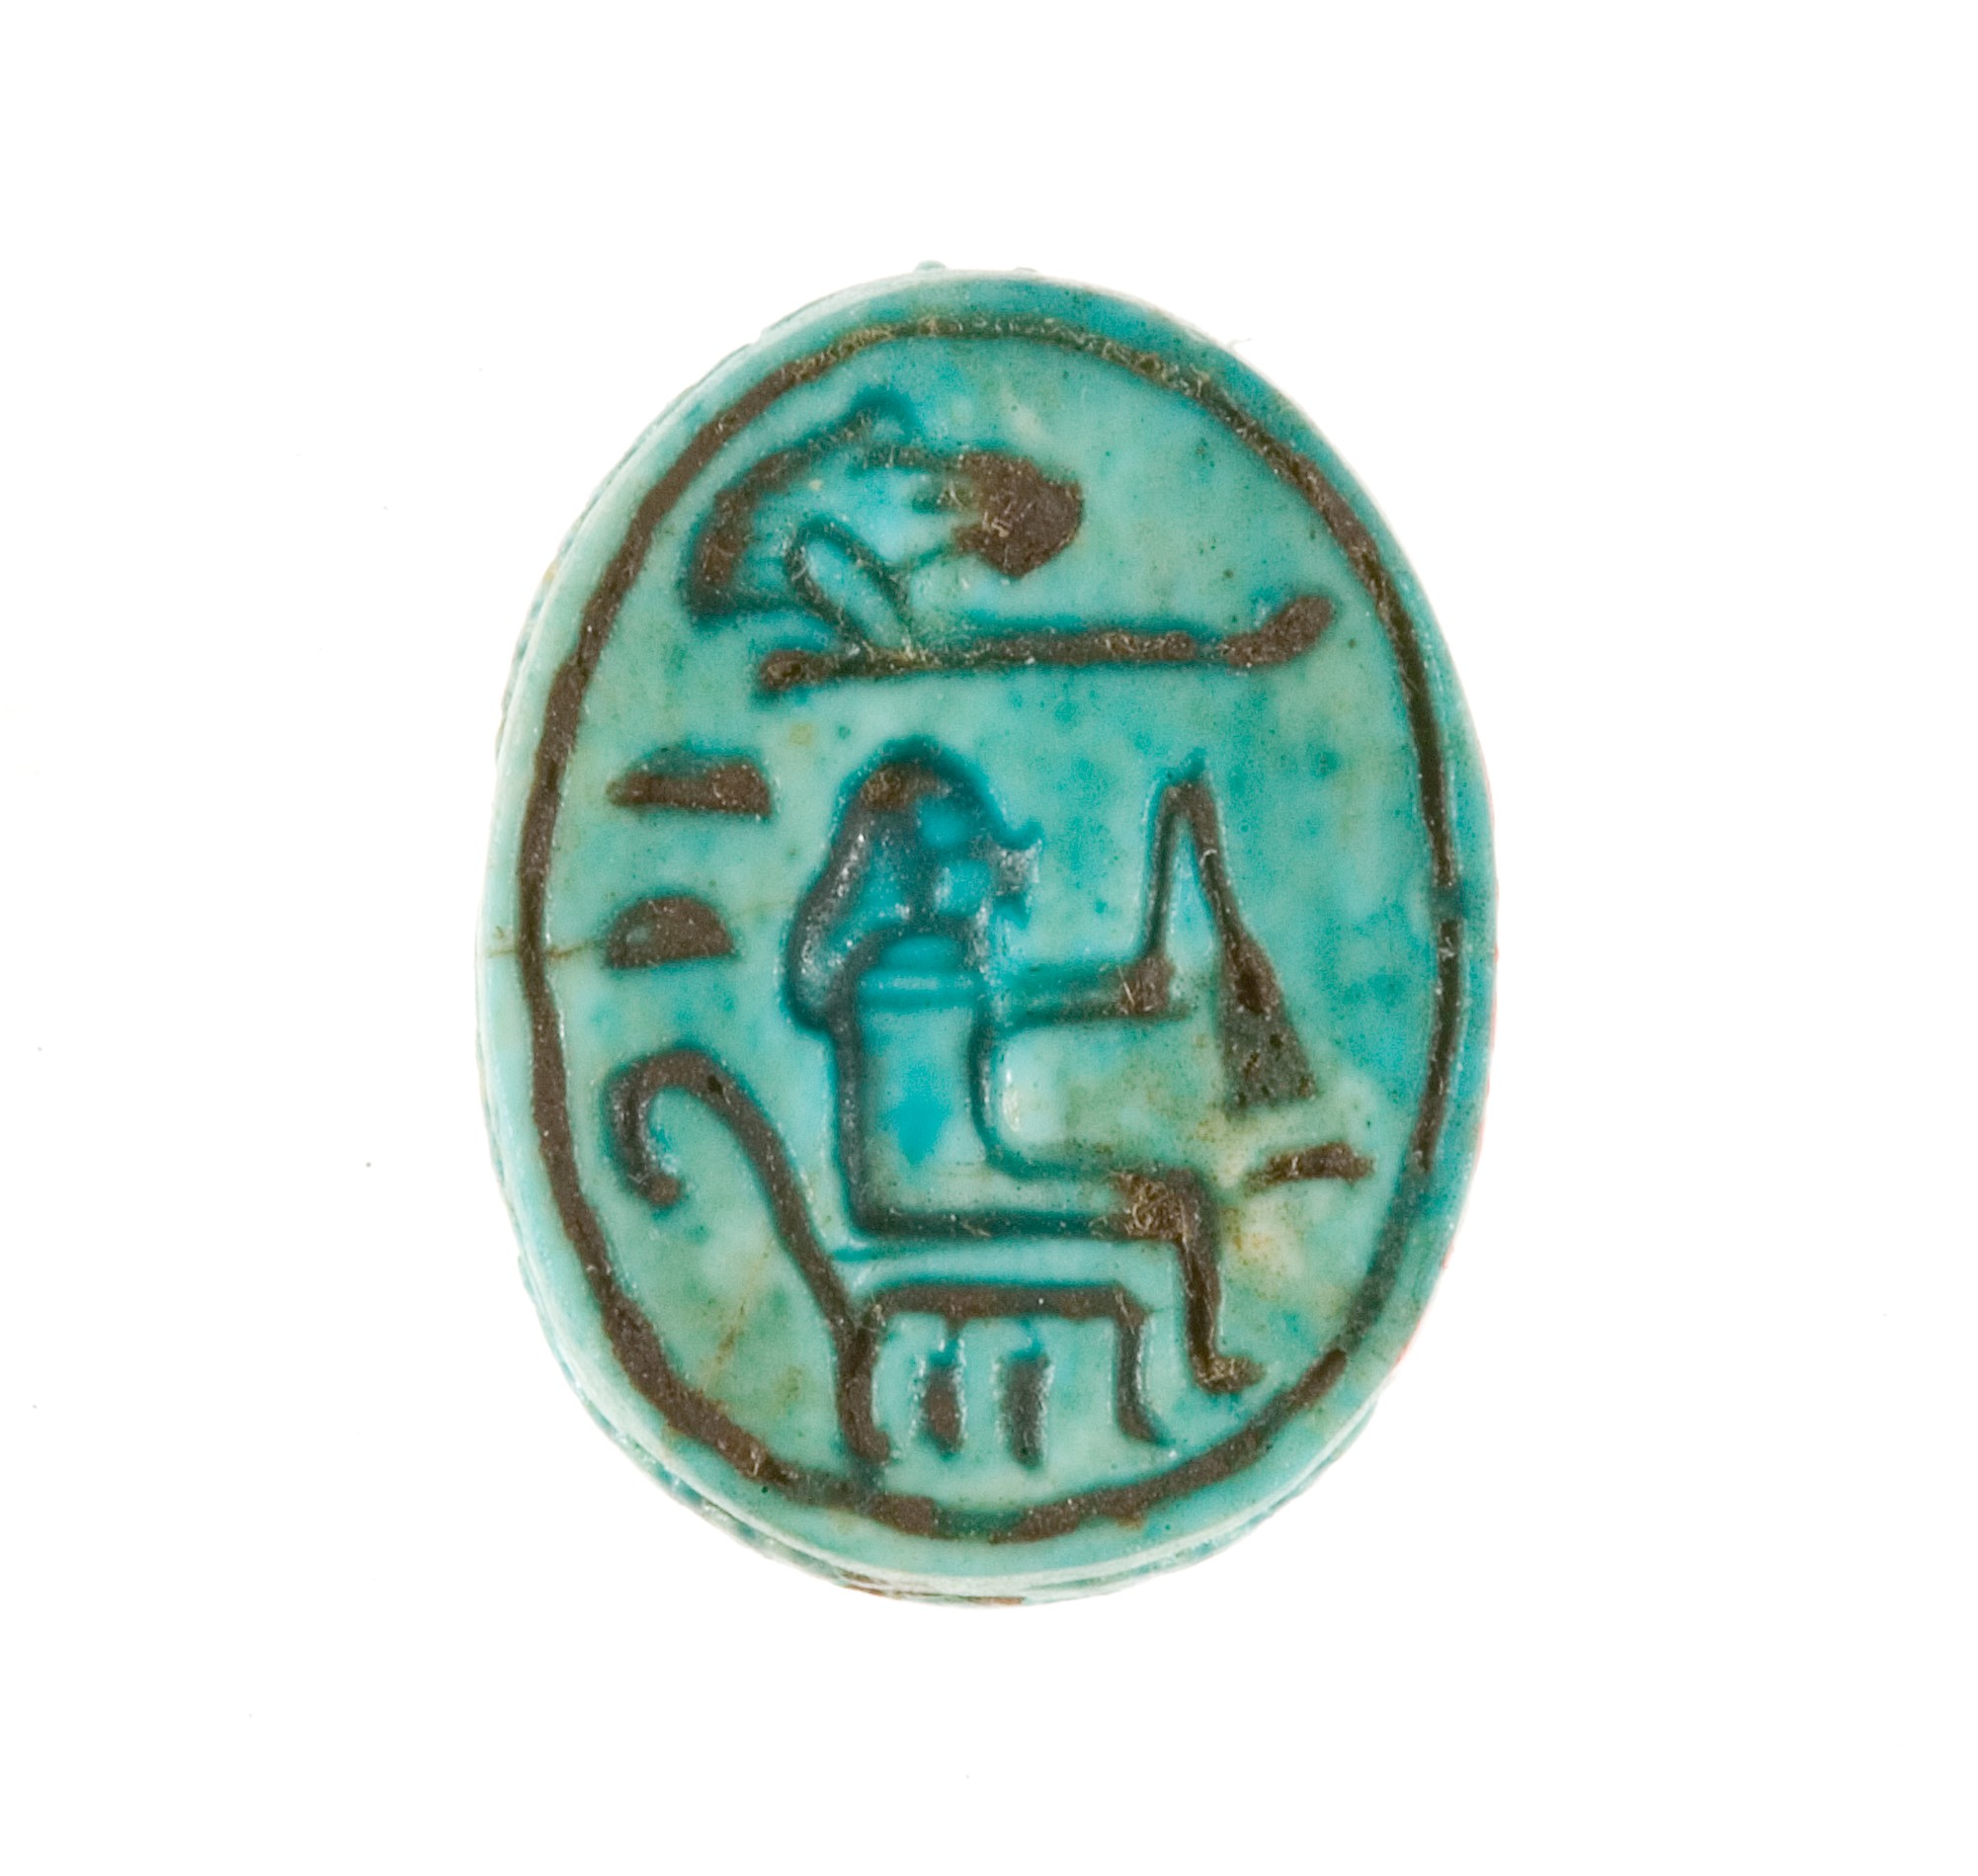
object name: scarab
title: Scarab Inscribed for Hatshepsut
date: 1479-1458 BCE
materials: stone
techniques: glazing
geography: egypt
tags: hieroglyphs,scarabs